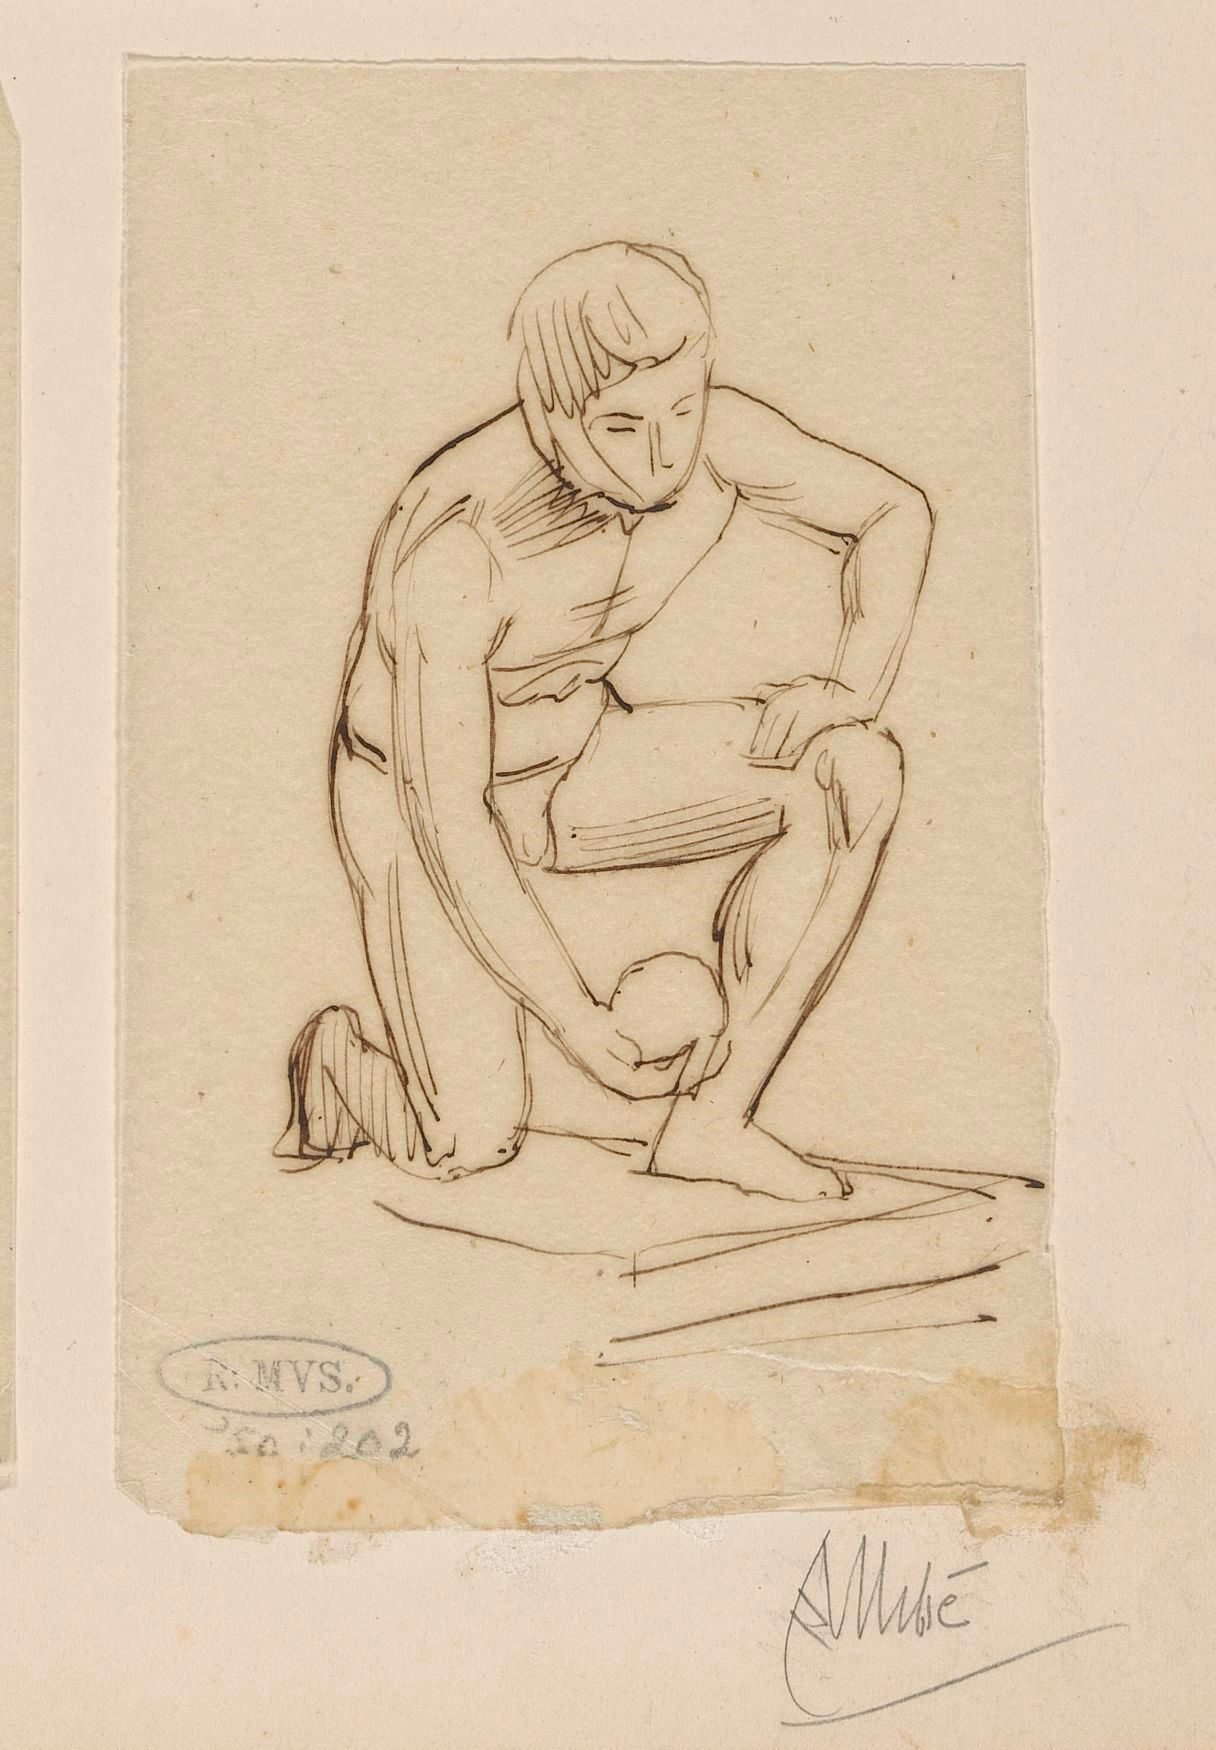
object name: drawing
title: Knielende naakte jongen met een bal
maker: august allebé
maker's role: draughtsman, print maker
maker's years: 1838-1927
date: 1848-1927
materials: ink, paper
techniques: pen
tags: the (nude) human figure; 'corpo humano' (ripa), piece of sculpture, reproduction of a piece of sculpture